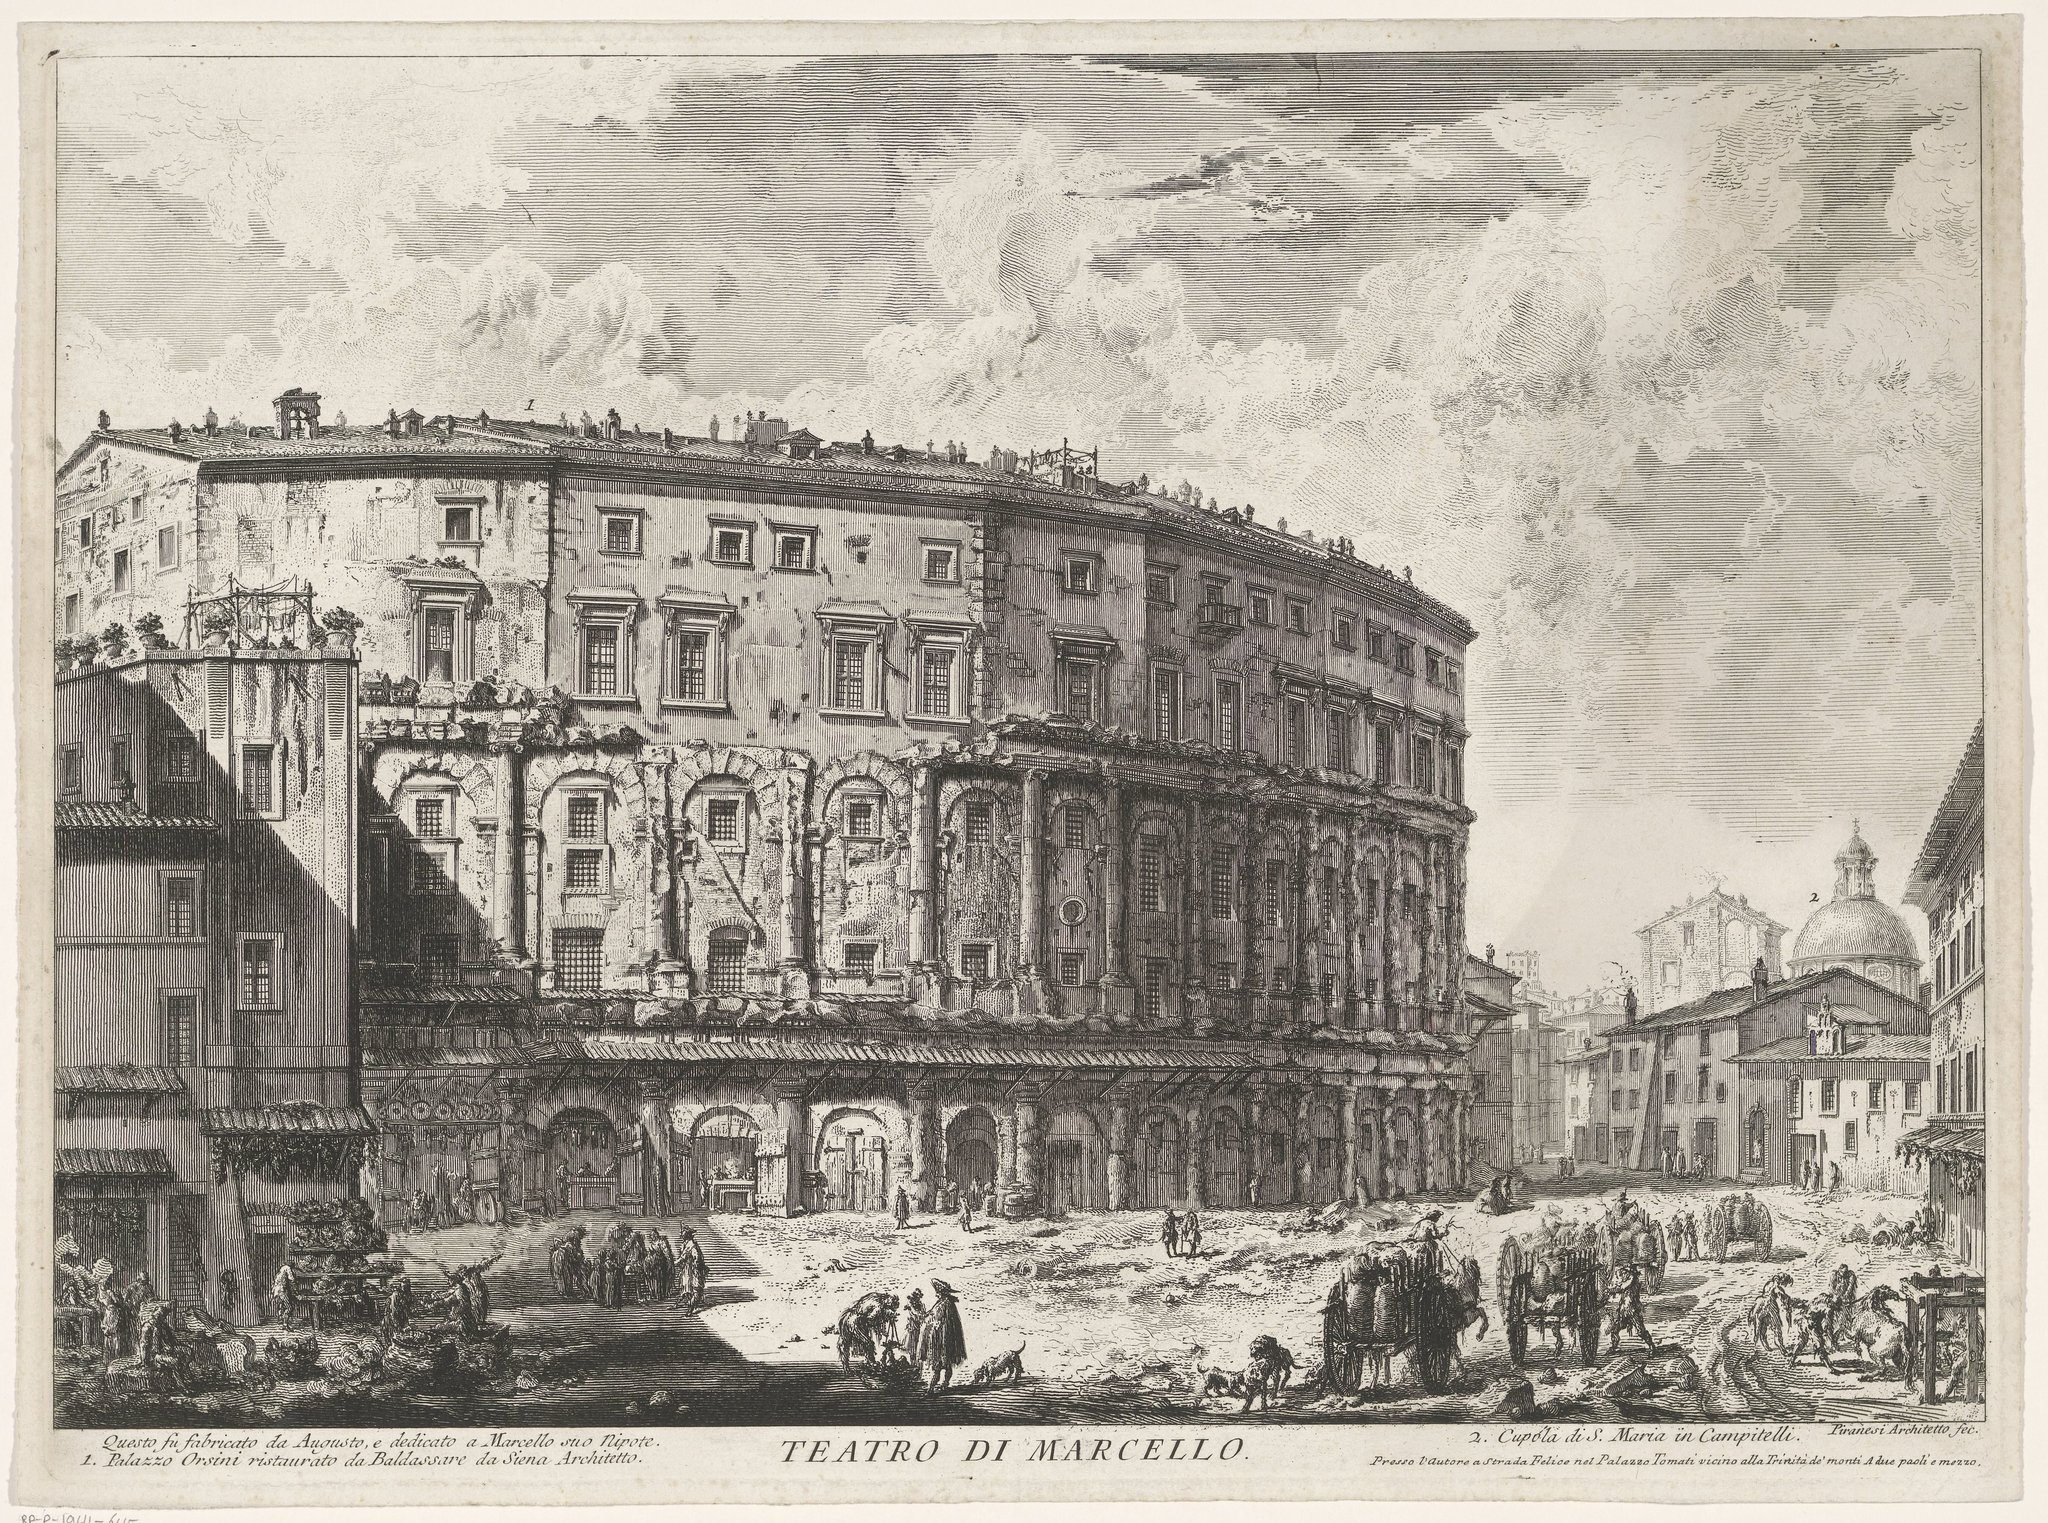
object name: print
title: Theater van Marcellus te Rome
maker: giovanni battista piranesi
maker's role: designer, draughtsman, print maker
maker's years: 1720-1778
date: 1748-1778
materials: paper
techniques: etching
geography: rome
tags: city-view, and landscape with man-made constructions, theatre (building) - aa - open-air performances, rome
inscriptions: collector's mark: Lugt 2228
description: Deze prent maakt deel uit van de serie 'Vedute di Roma'. Piranesi werkte aan deze 135 platen tellende serie tussen 1748 en zijn dood in 1778. Francesco Piranesi voegde later nog twee prenten toe aan de reeks van zijn vader.